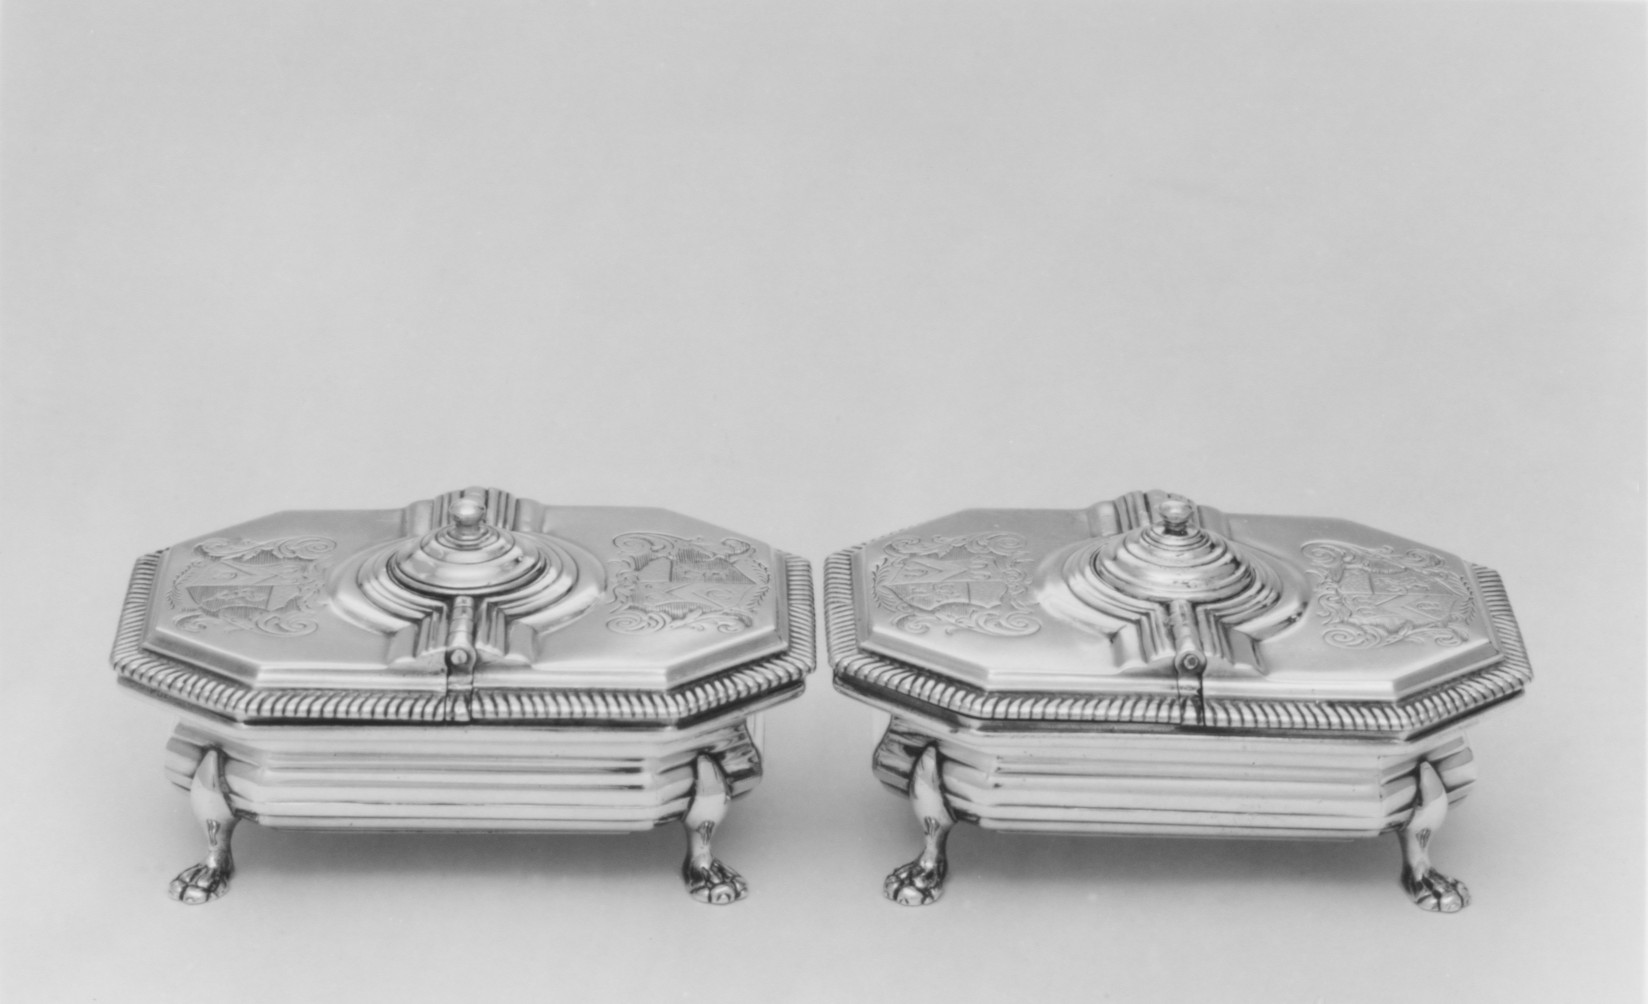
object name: spice box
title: Pair of spice boxes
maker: david willaume i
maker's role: maker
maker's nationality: british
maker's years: 1658-1741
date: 1709-1710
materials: gilt, silver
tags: coat of arms